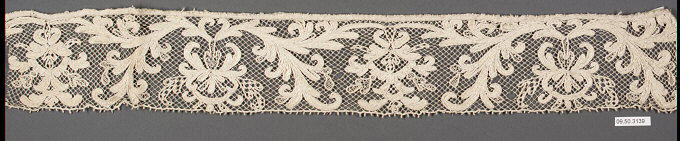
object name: fragment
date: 1701-1800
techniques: embroidery